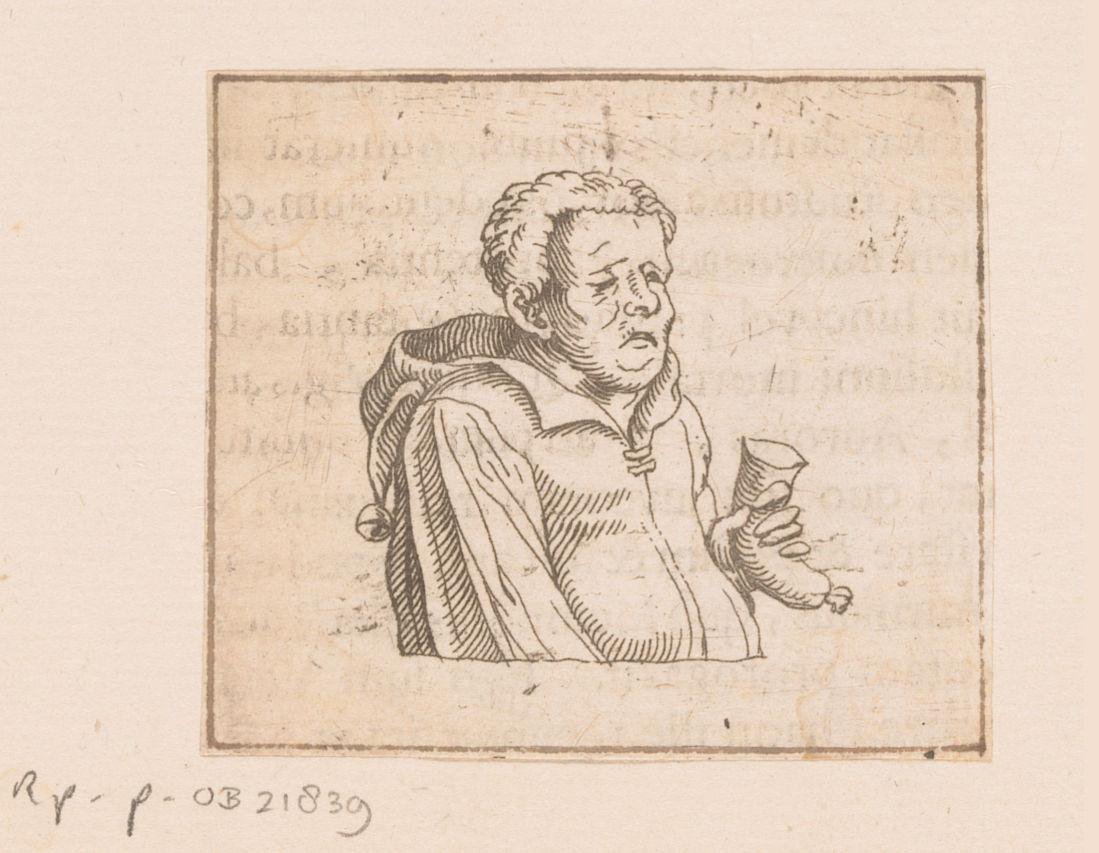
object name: print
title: Illustraties uit de Lof der Zotheid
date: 1516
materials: paper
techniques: etching, letterpress printing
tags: rotterdam, desiderius erasmus, court jester, court fool, folly, foolishness; 'pazzia', 'sciocchezza', 'stoltitia' (ripa), sausage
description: Prent afkomstig uit: Erasmus, Desiderius. Morias enkomion (...). Bazel: Johann Rudolf Genath, 1676. De prenten hierin zijn naar tekeningen die Hans en Ambrosius Holbein maakten voor de theoloog Oswald Myconius in diens uitgave van de Moriae encomium (Lof der Zotheid) van 1516.